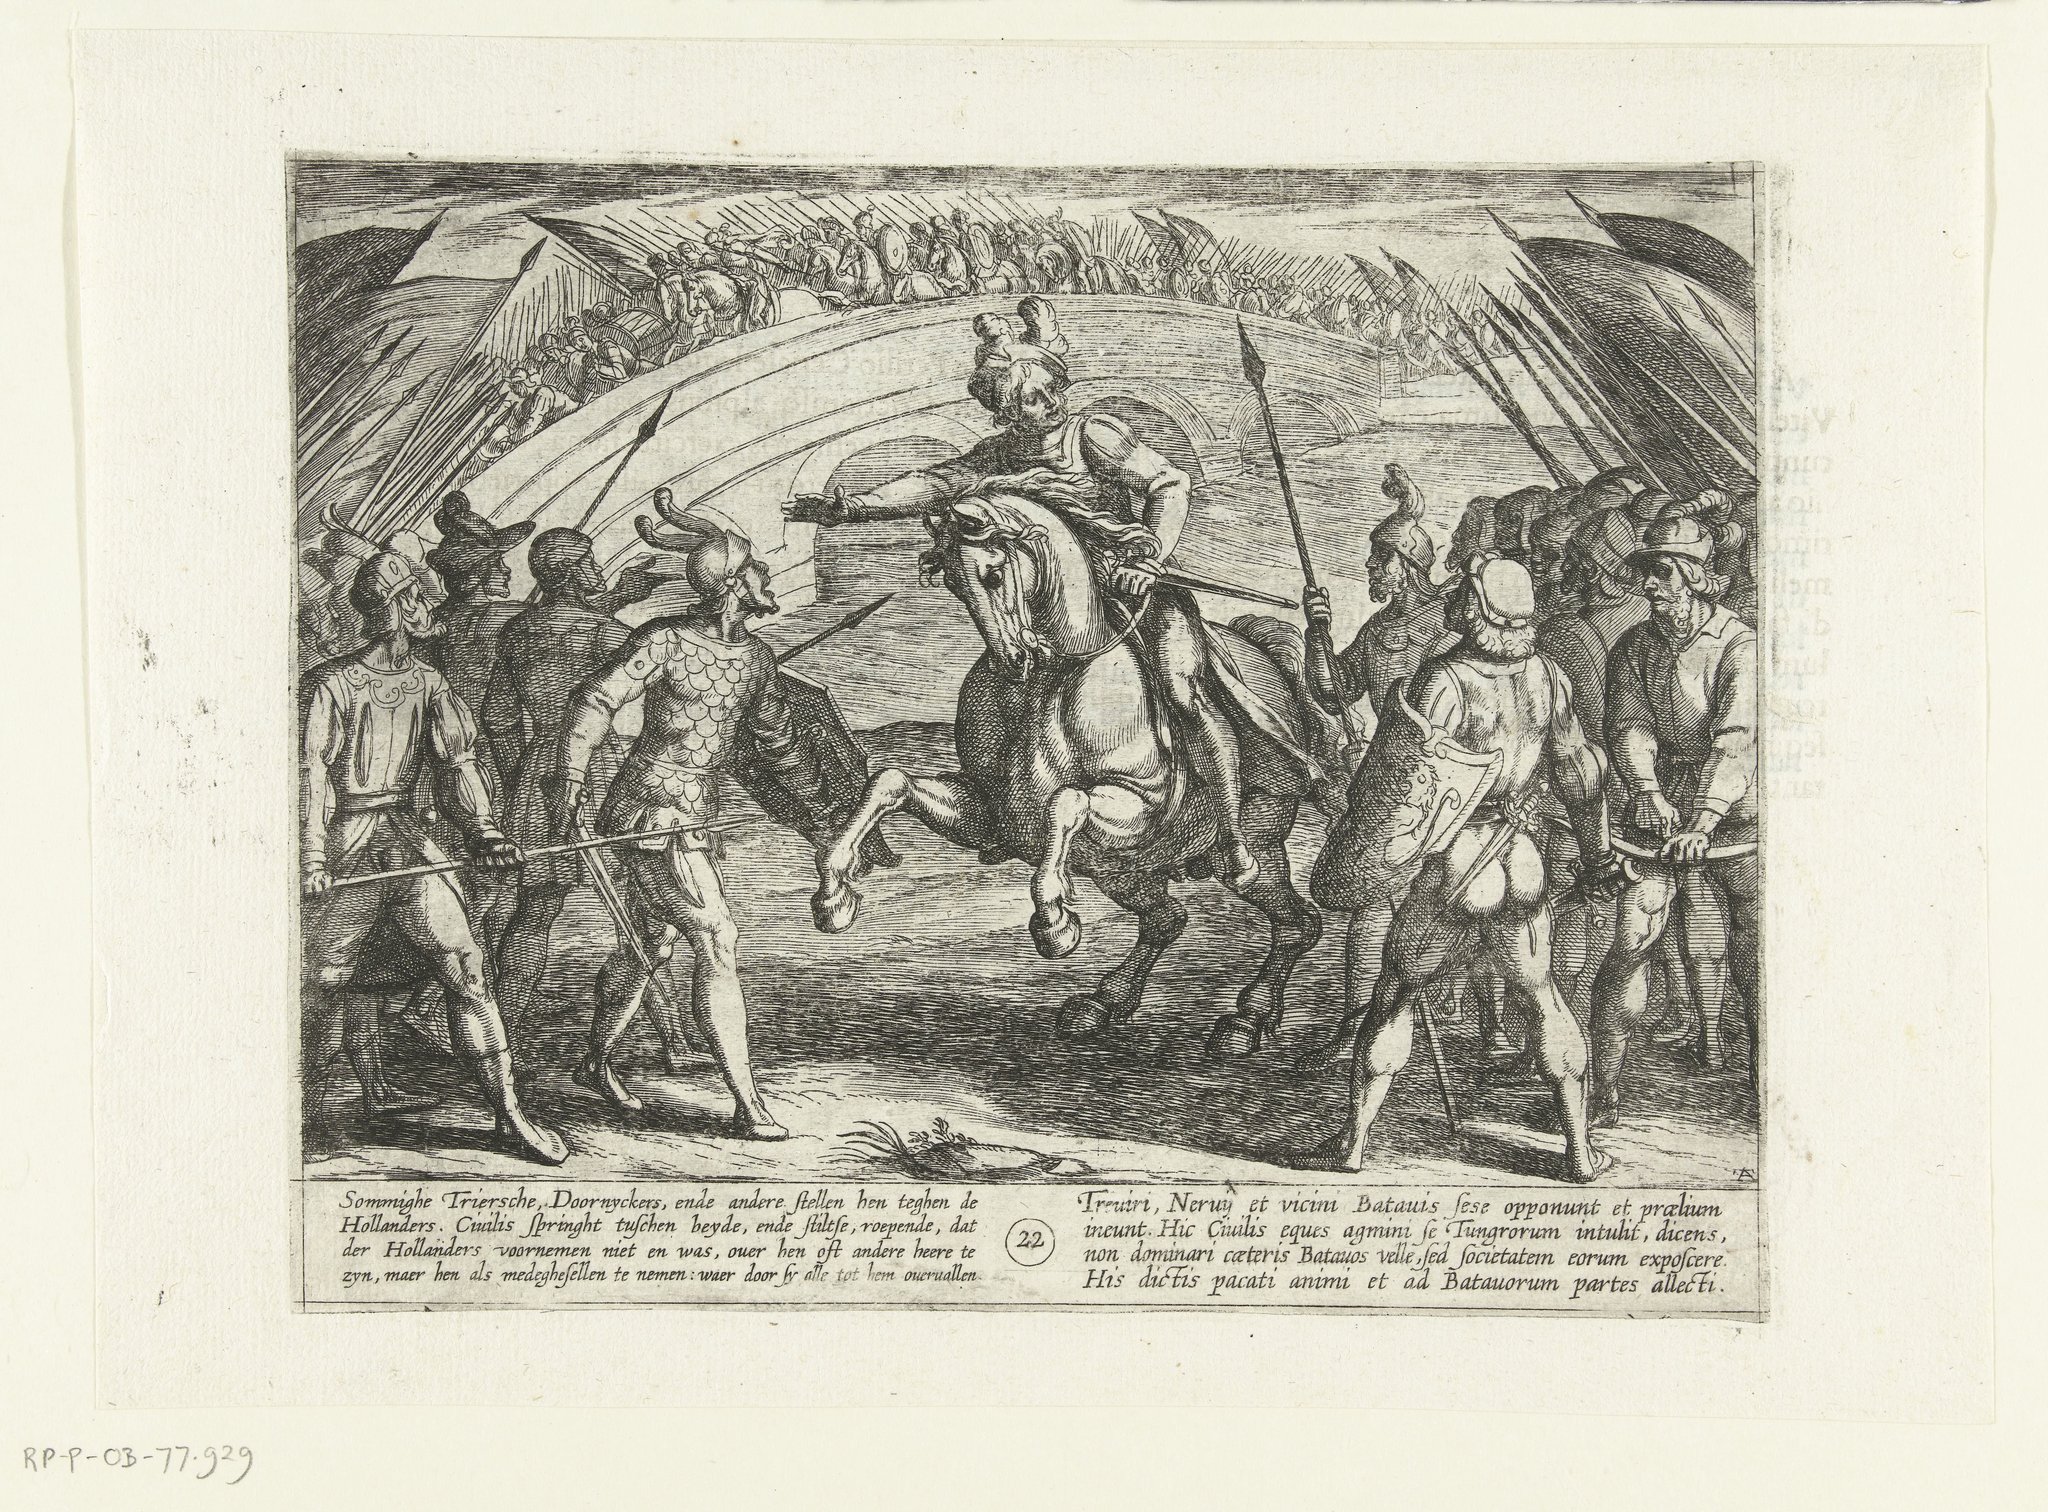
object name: history print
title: Batavorum cum Romanis Bellum, à Corn. Tacito / De Batavische Oft Oude Hollandtsche Oorloghe teghen de Romeynen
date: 1612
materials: paper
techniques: etching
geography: italy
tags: battle, fighting in general, extinct, 'historical' peoples (with name), netherlands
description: Civilis komt tussenbeide en voorkomt dat de Nederlandse en de Duitse soldaten met elkaar slaags raken. Prent nummer 22 in de serie prenten over de Bataafse Opstand: Batavorum cum Romanis bellum / à Corn. Tacito lib. IV & V. : Hist. olim descriptum, figuris nunc aeneis expressum, auctore Othone Vaenio Lugdunobatava = De Batavische oft oude Hollandtsche oorloghe teghen de Romeynen. Otto Vaenius, Antwerpen 1612. Onderaan twee verzen van vier regels in het Nederlands en in het Latijn. Op de achterzijde tekst in het Latijn.